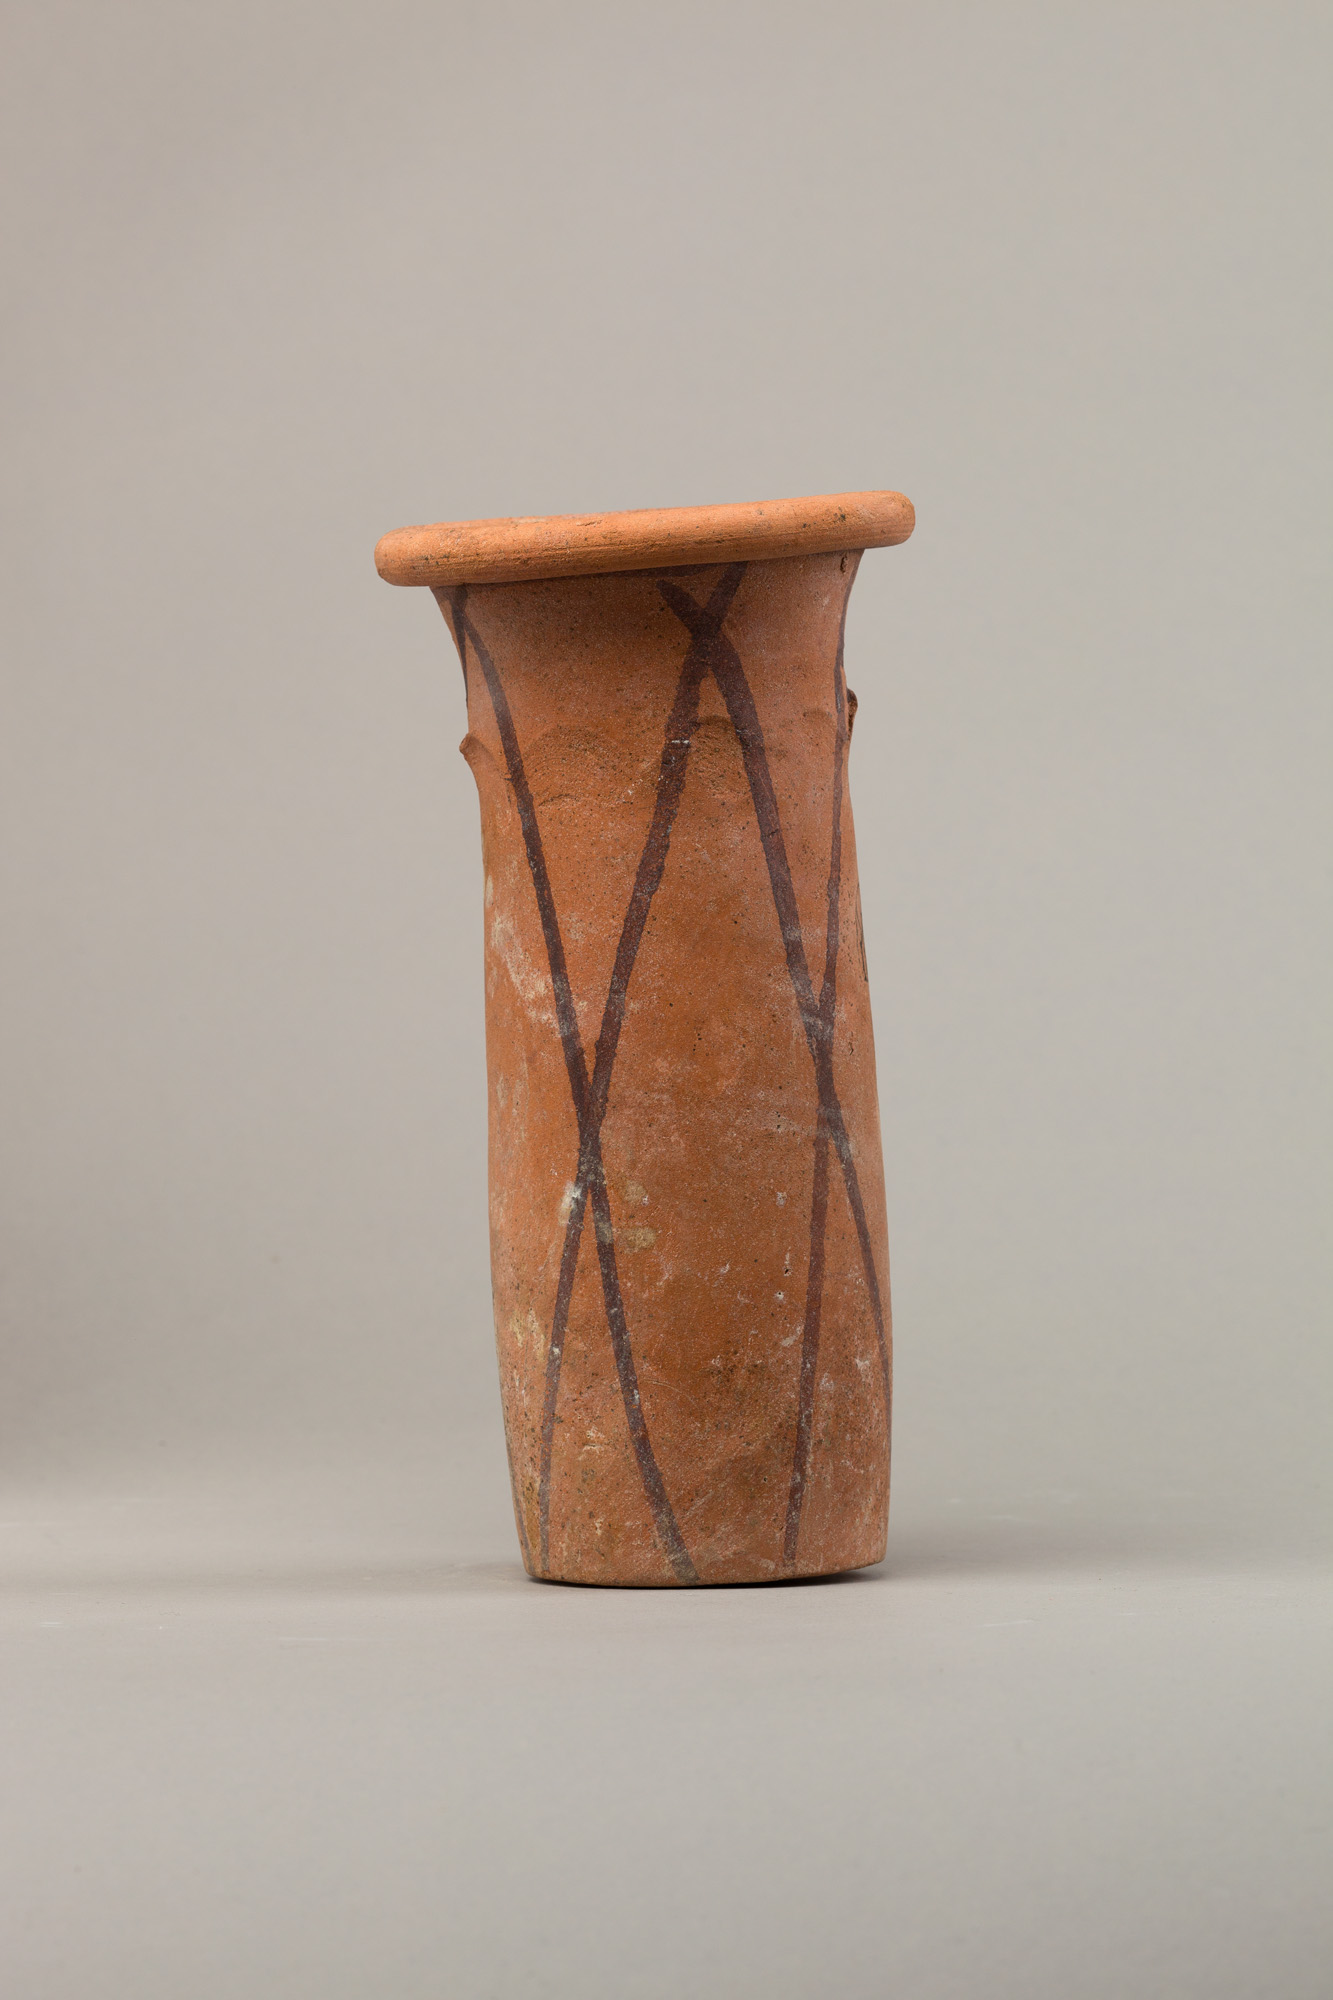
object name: jar, wavy handled, zebra, quagga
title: Wavy-handled jar with cross-lined decoration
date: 3100-2649 BCE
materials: paint, pottery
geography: egypt